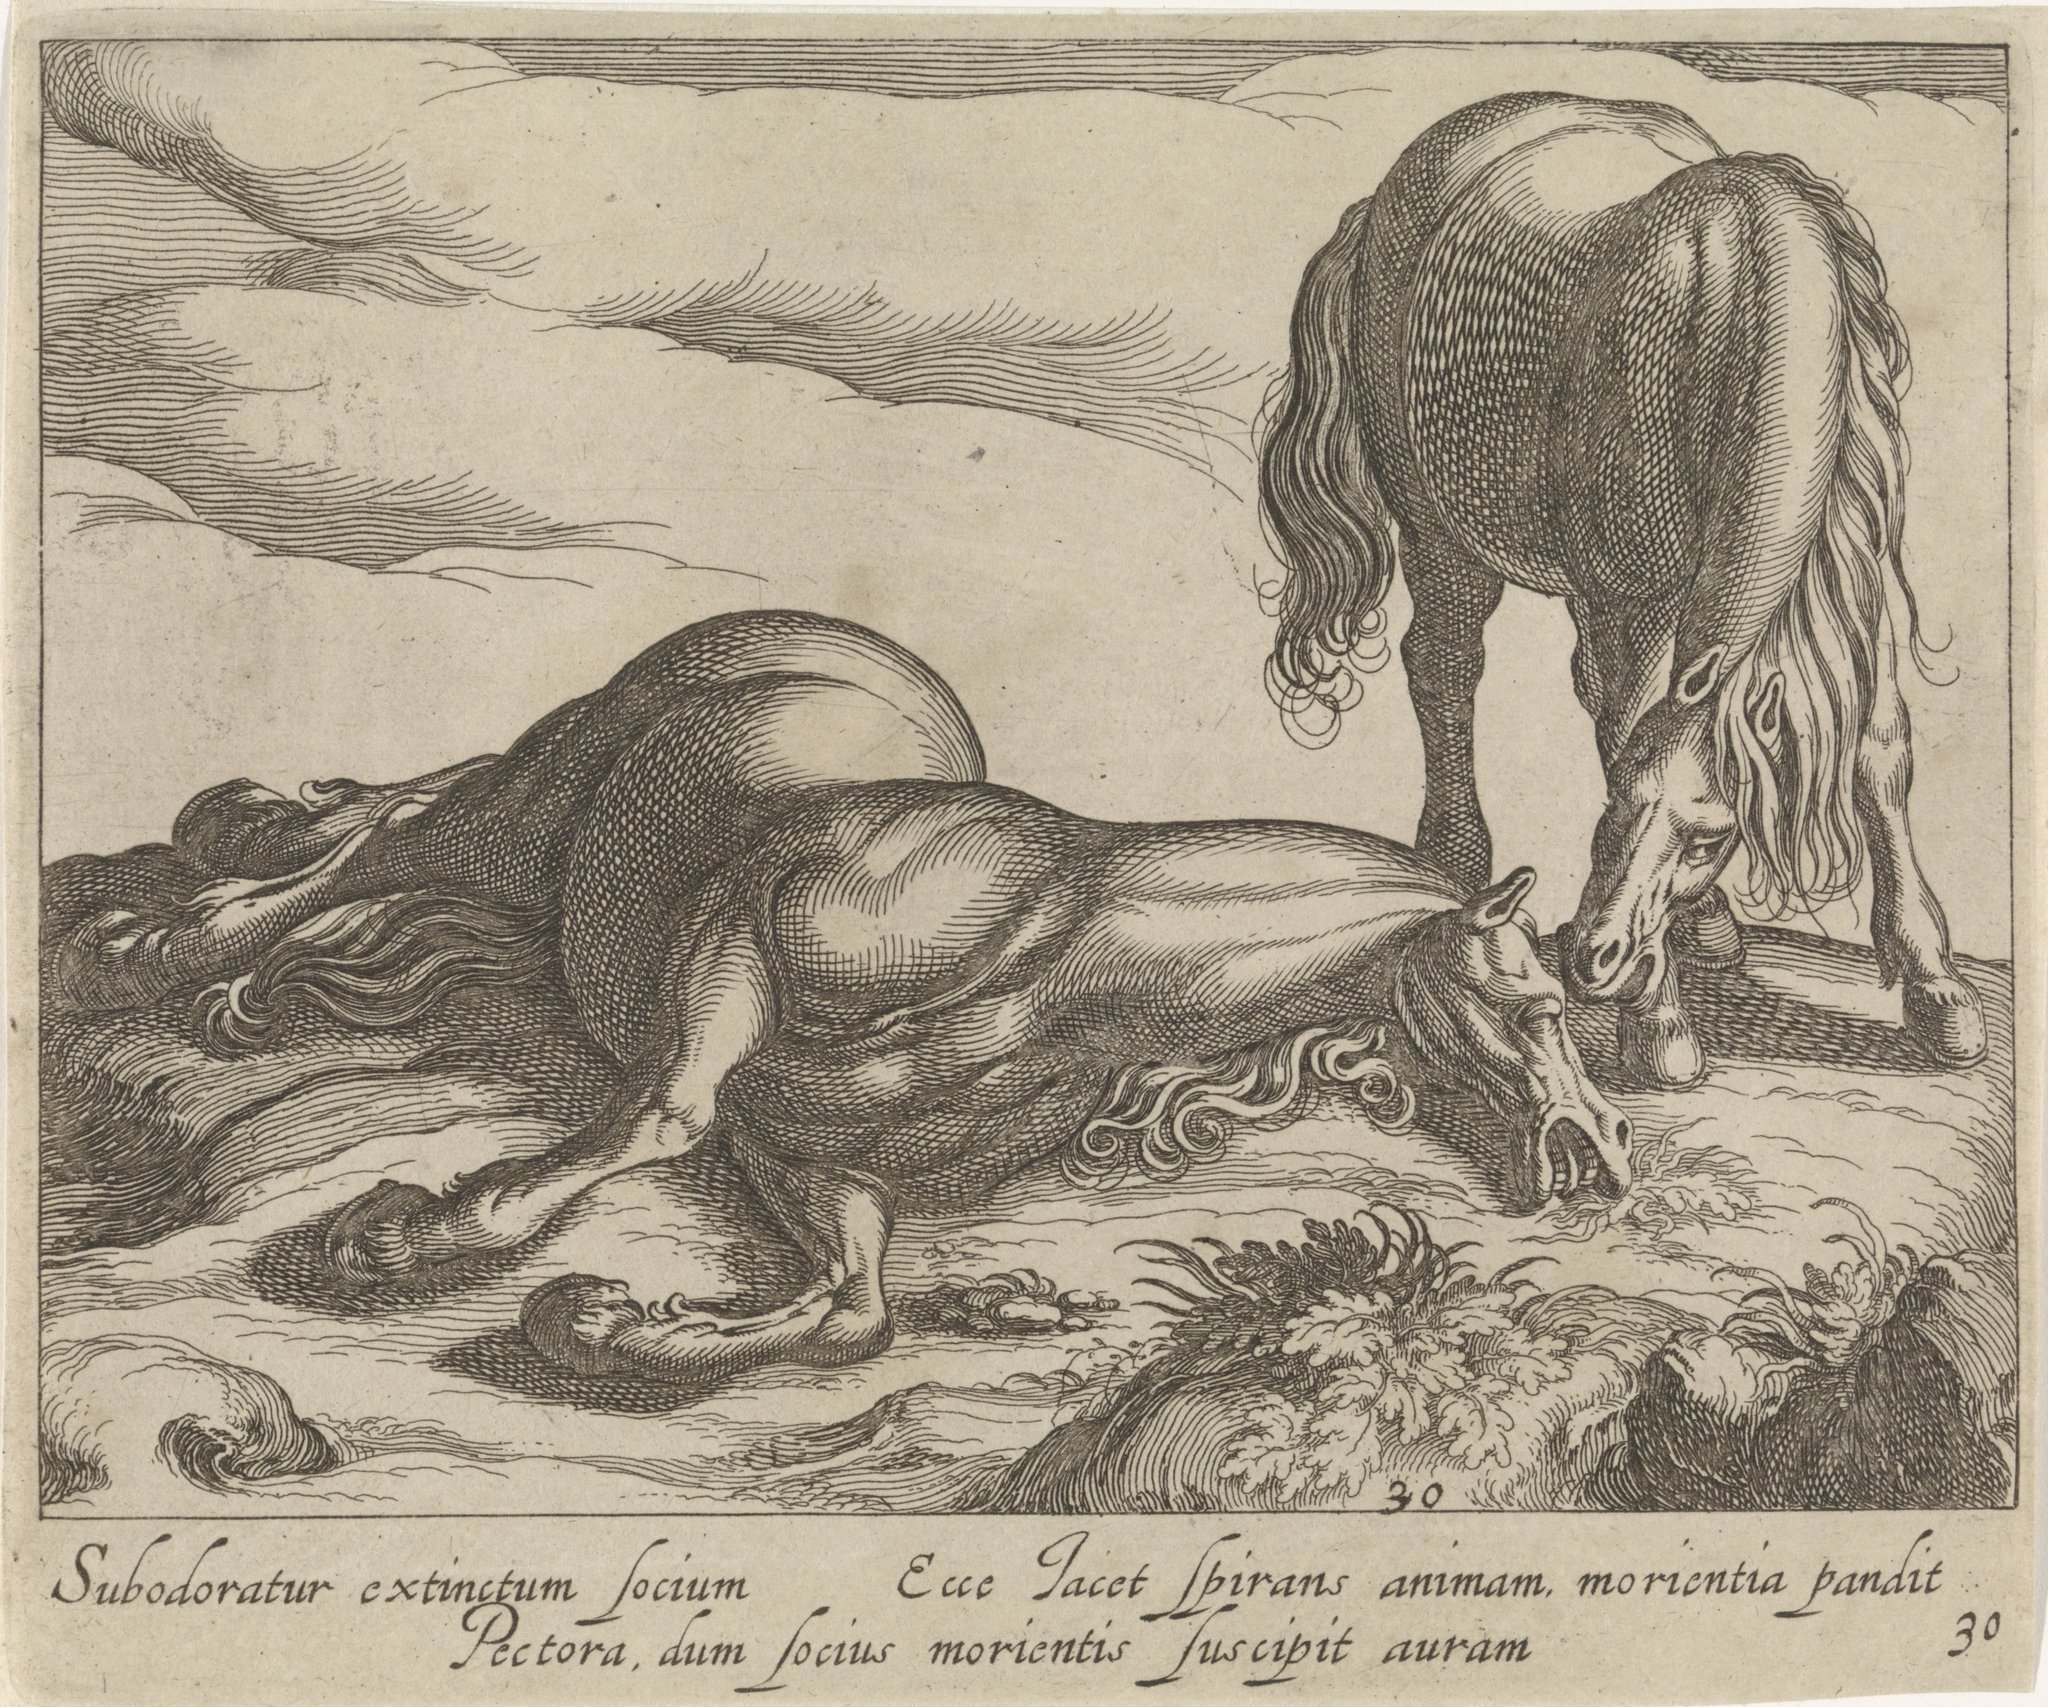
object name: print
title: Landschap met dood paard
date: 1590-1637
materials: paper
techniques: engraving, etching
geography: amsterdam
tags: horse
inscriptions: collector's mark: Lugt 2228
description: Landschap met op de voorgrond een dood paard, liggend op de grond, naar rechts gekeerd. Het andere paard snuffelt aan zijn hoofd. In de marge een tweeregelig onderschrift in het Latijn. Prent uit een serie van dertig met paardenrassen.